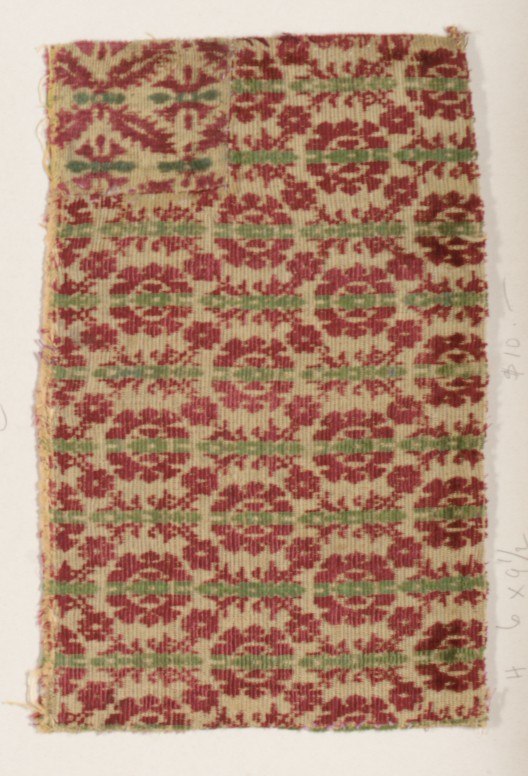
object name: fragment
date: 1701-1800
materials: metal thread, silk